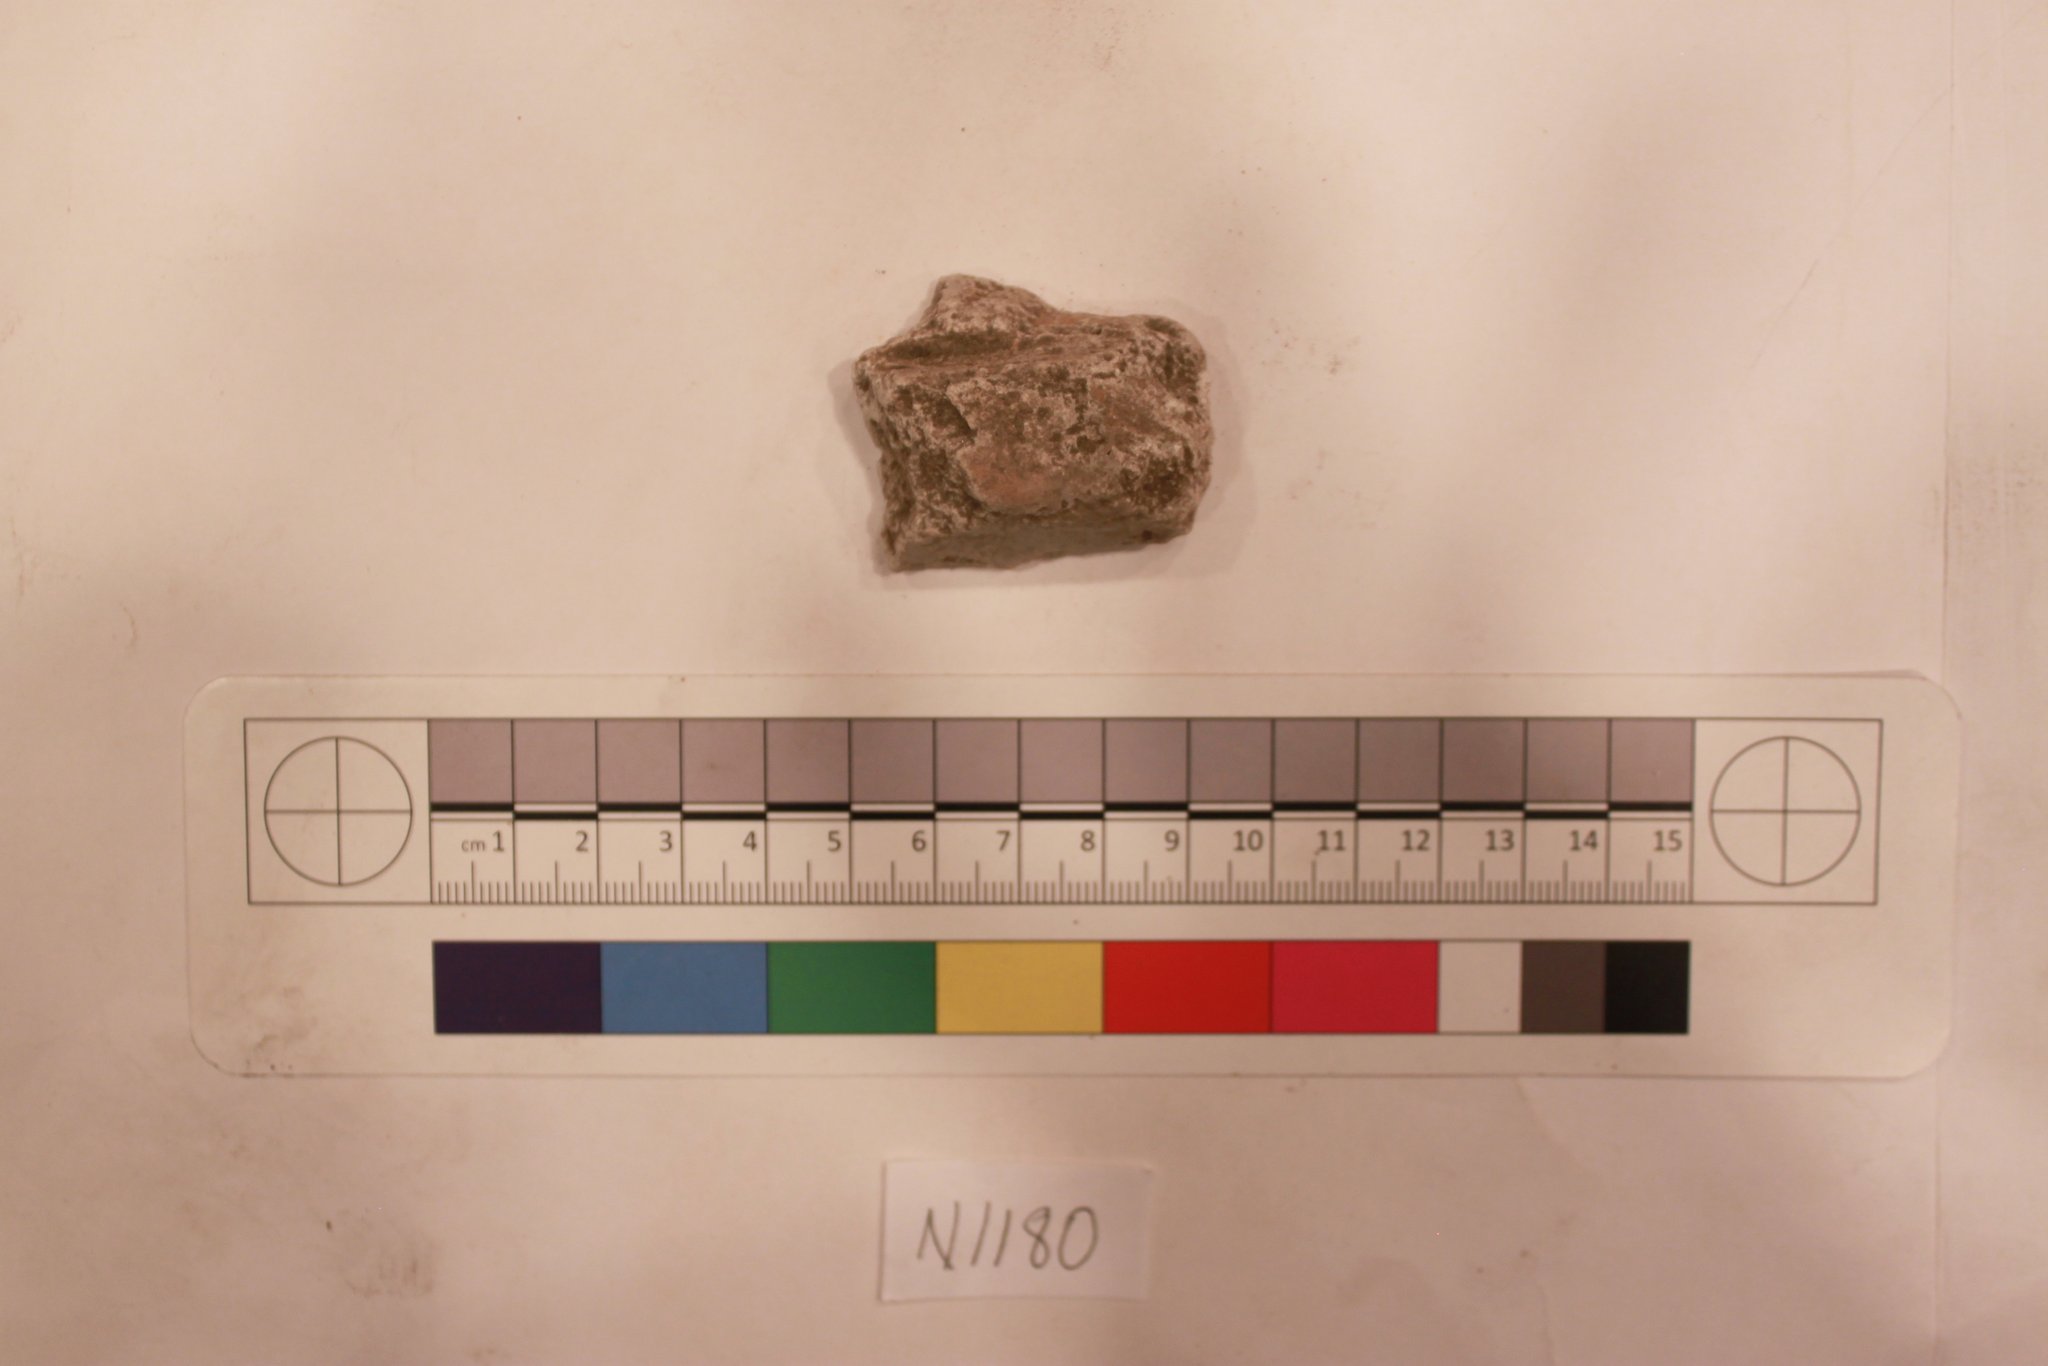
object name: fragment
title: Stucco Fragment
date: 701-1200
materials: plaster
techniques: carving, painting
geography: iran